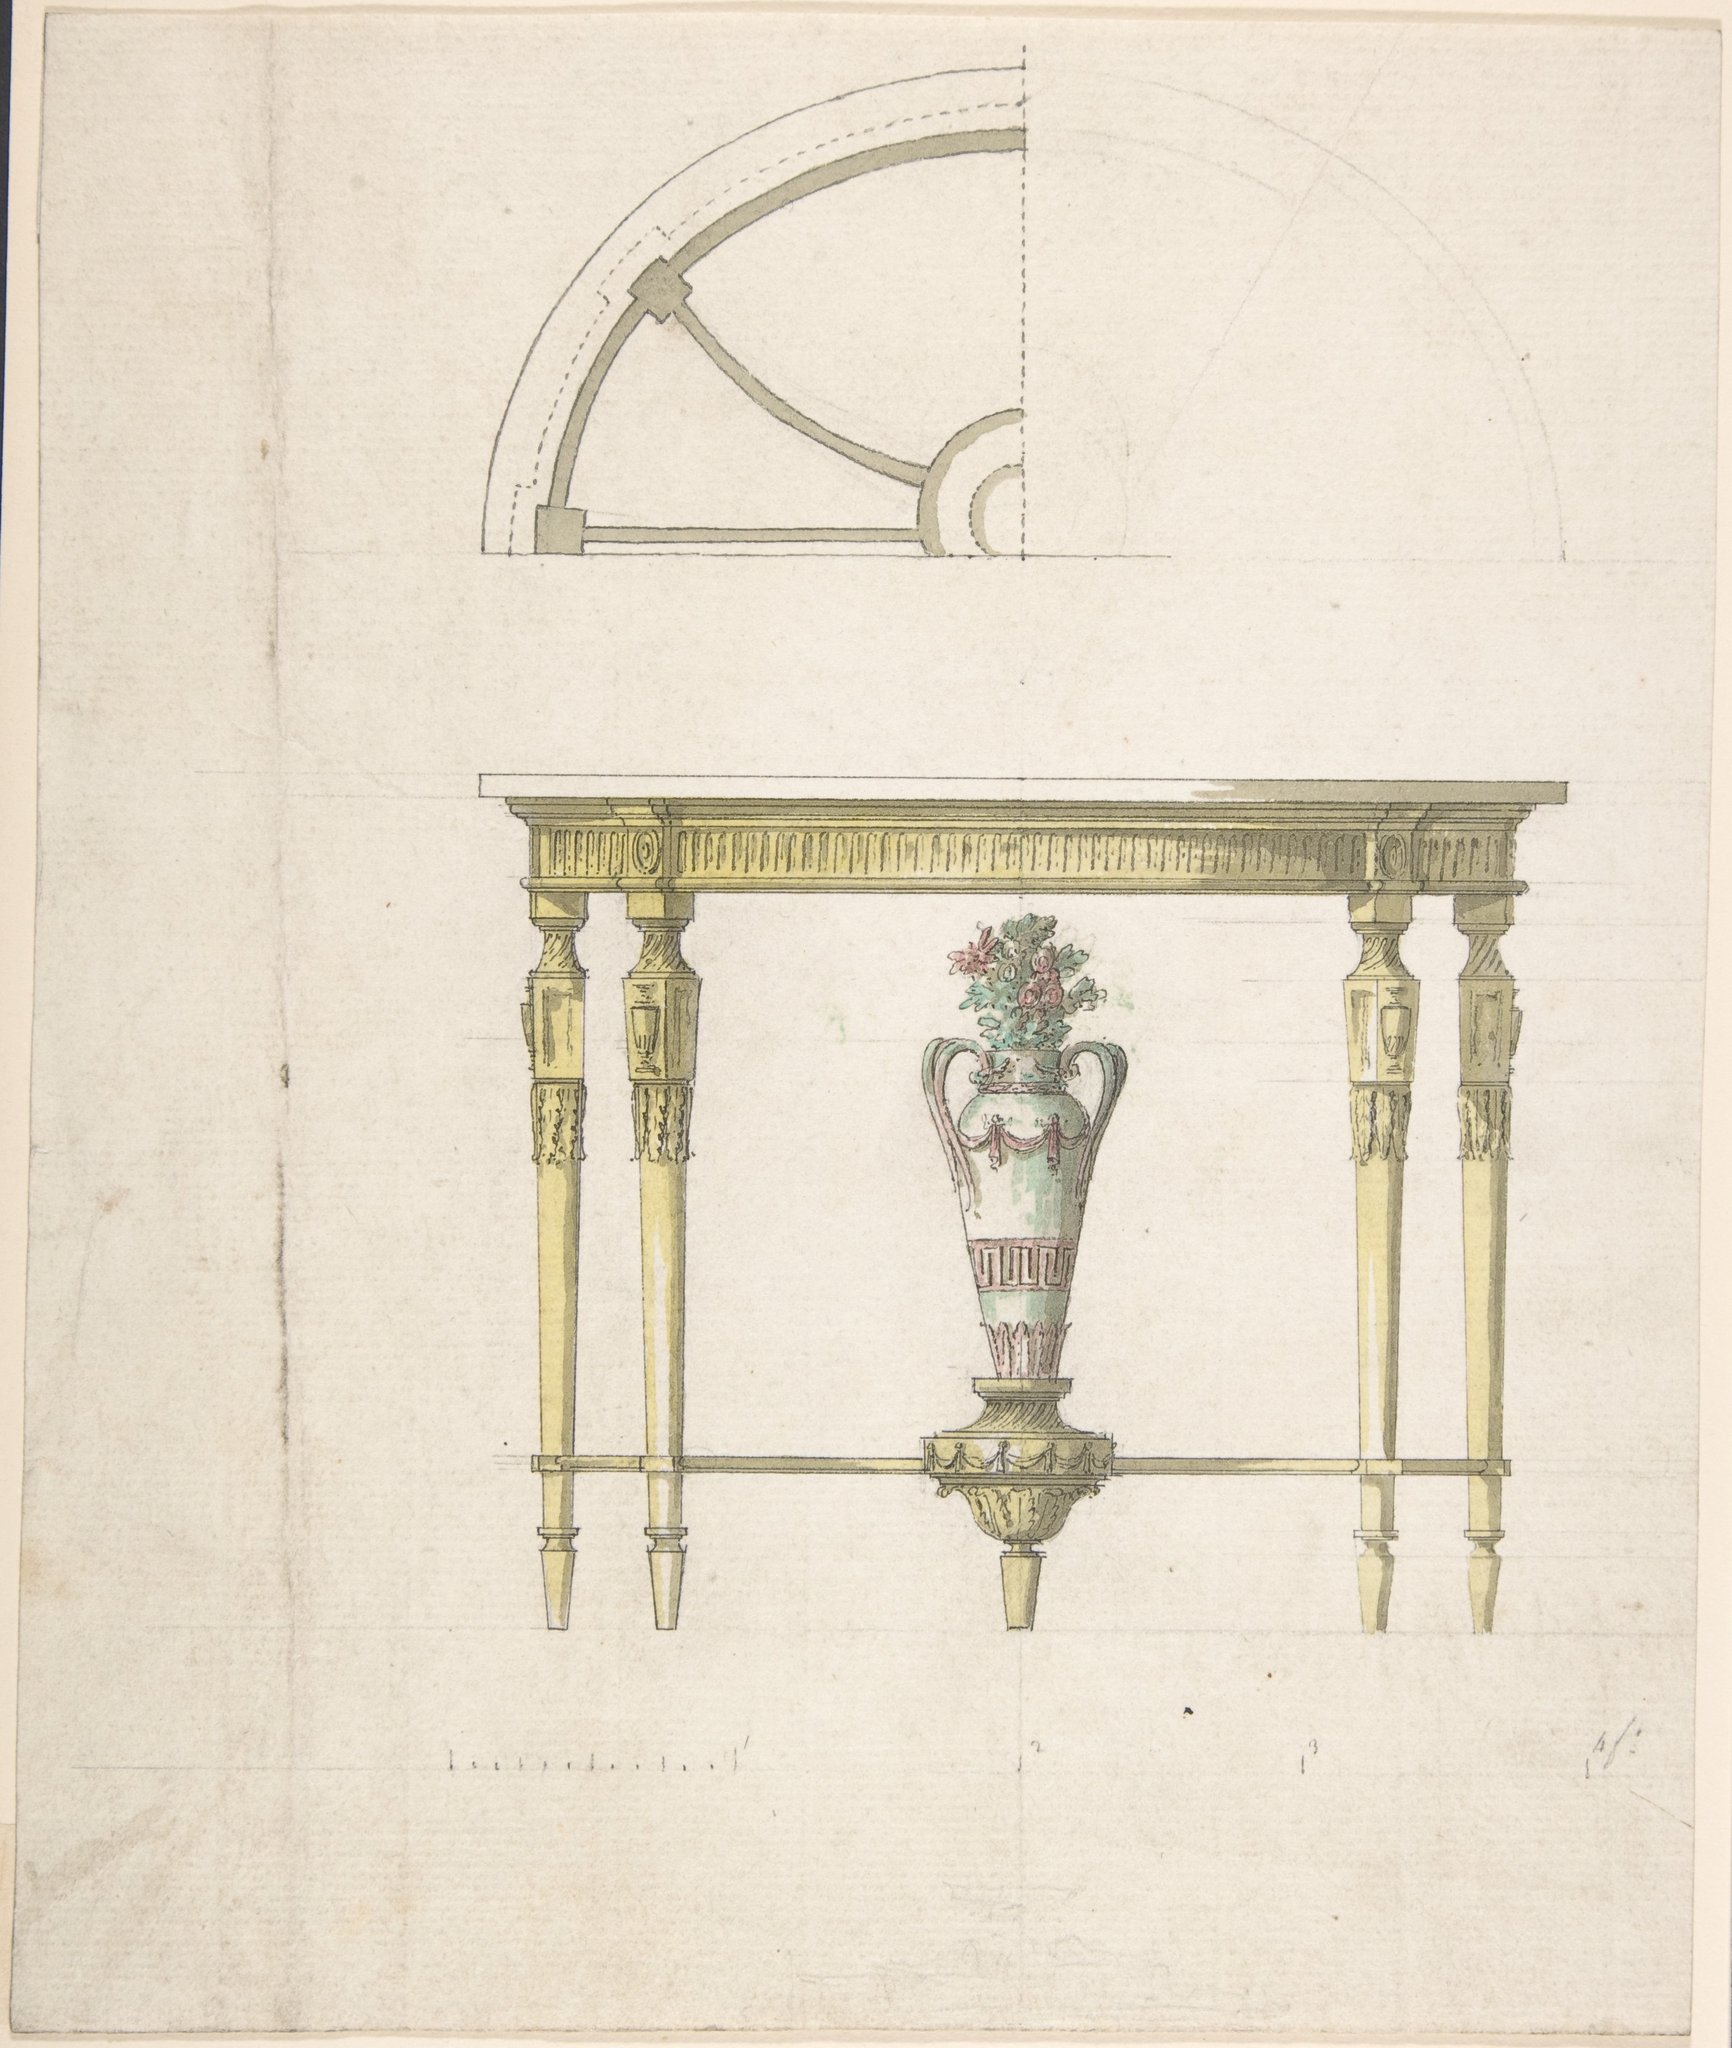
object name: drawing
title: Design for a Console Table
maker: robert adam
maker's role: artist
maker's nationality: british, scottish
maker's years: 1728-1792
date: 1751-1800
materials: graphite, ink, watercolor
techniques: pen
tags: tables